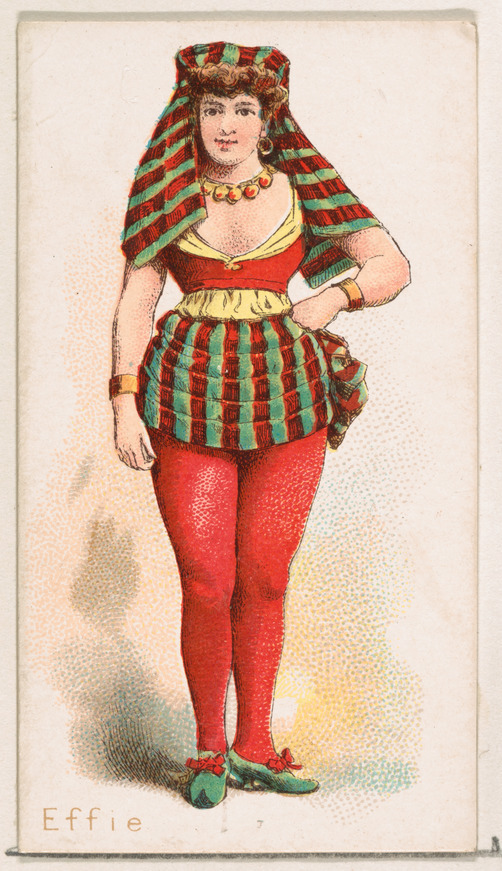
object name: print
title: Effie, from the Ballet Queens series (N182) issued by Wm. S. Kimball & Co.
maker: william s. kimball & company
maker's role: publisher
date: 1889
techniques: color lithograph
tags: women